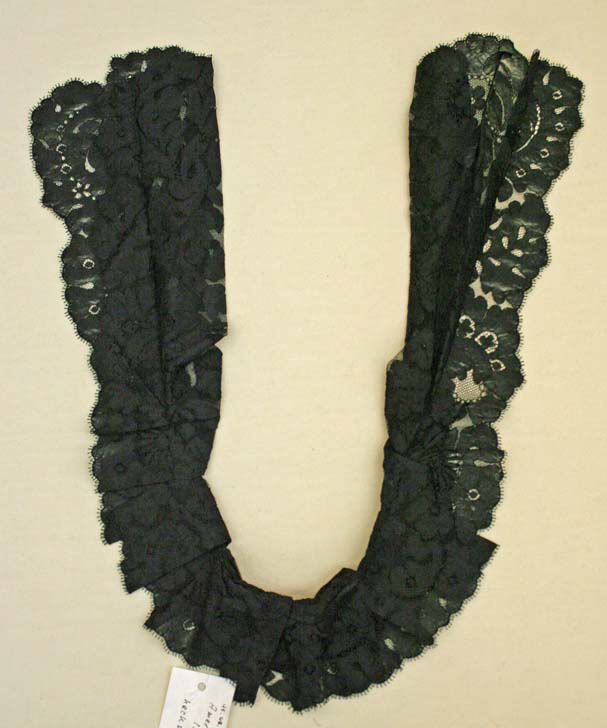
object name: neckpiece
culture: american or european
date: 1700-1945